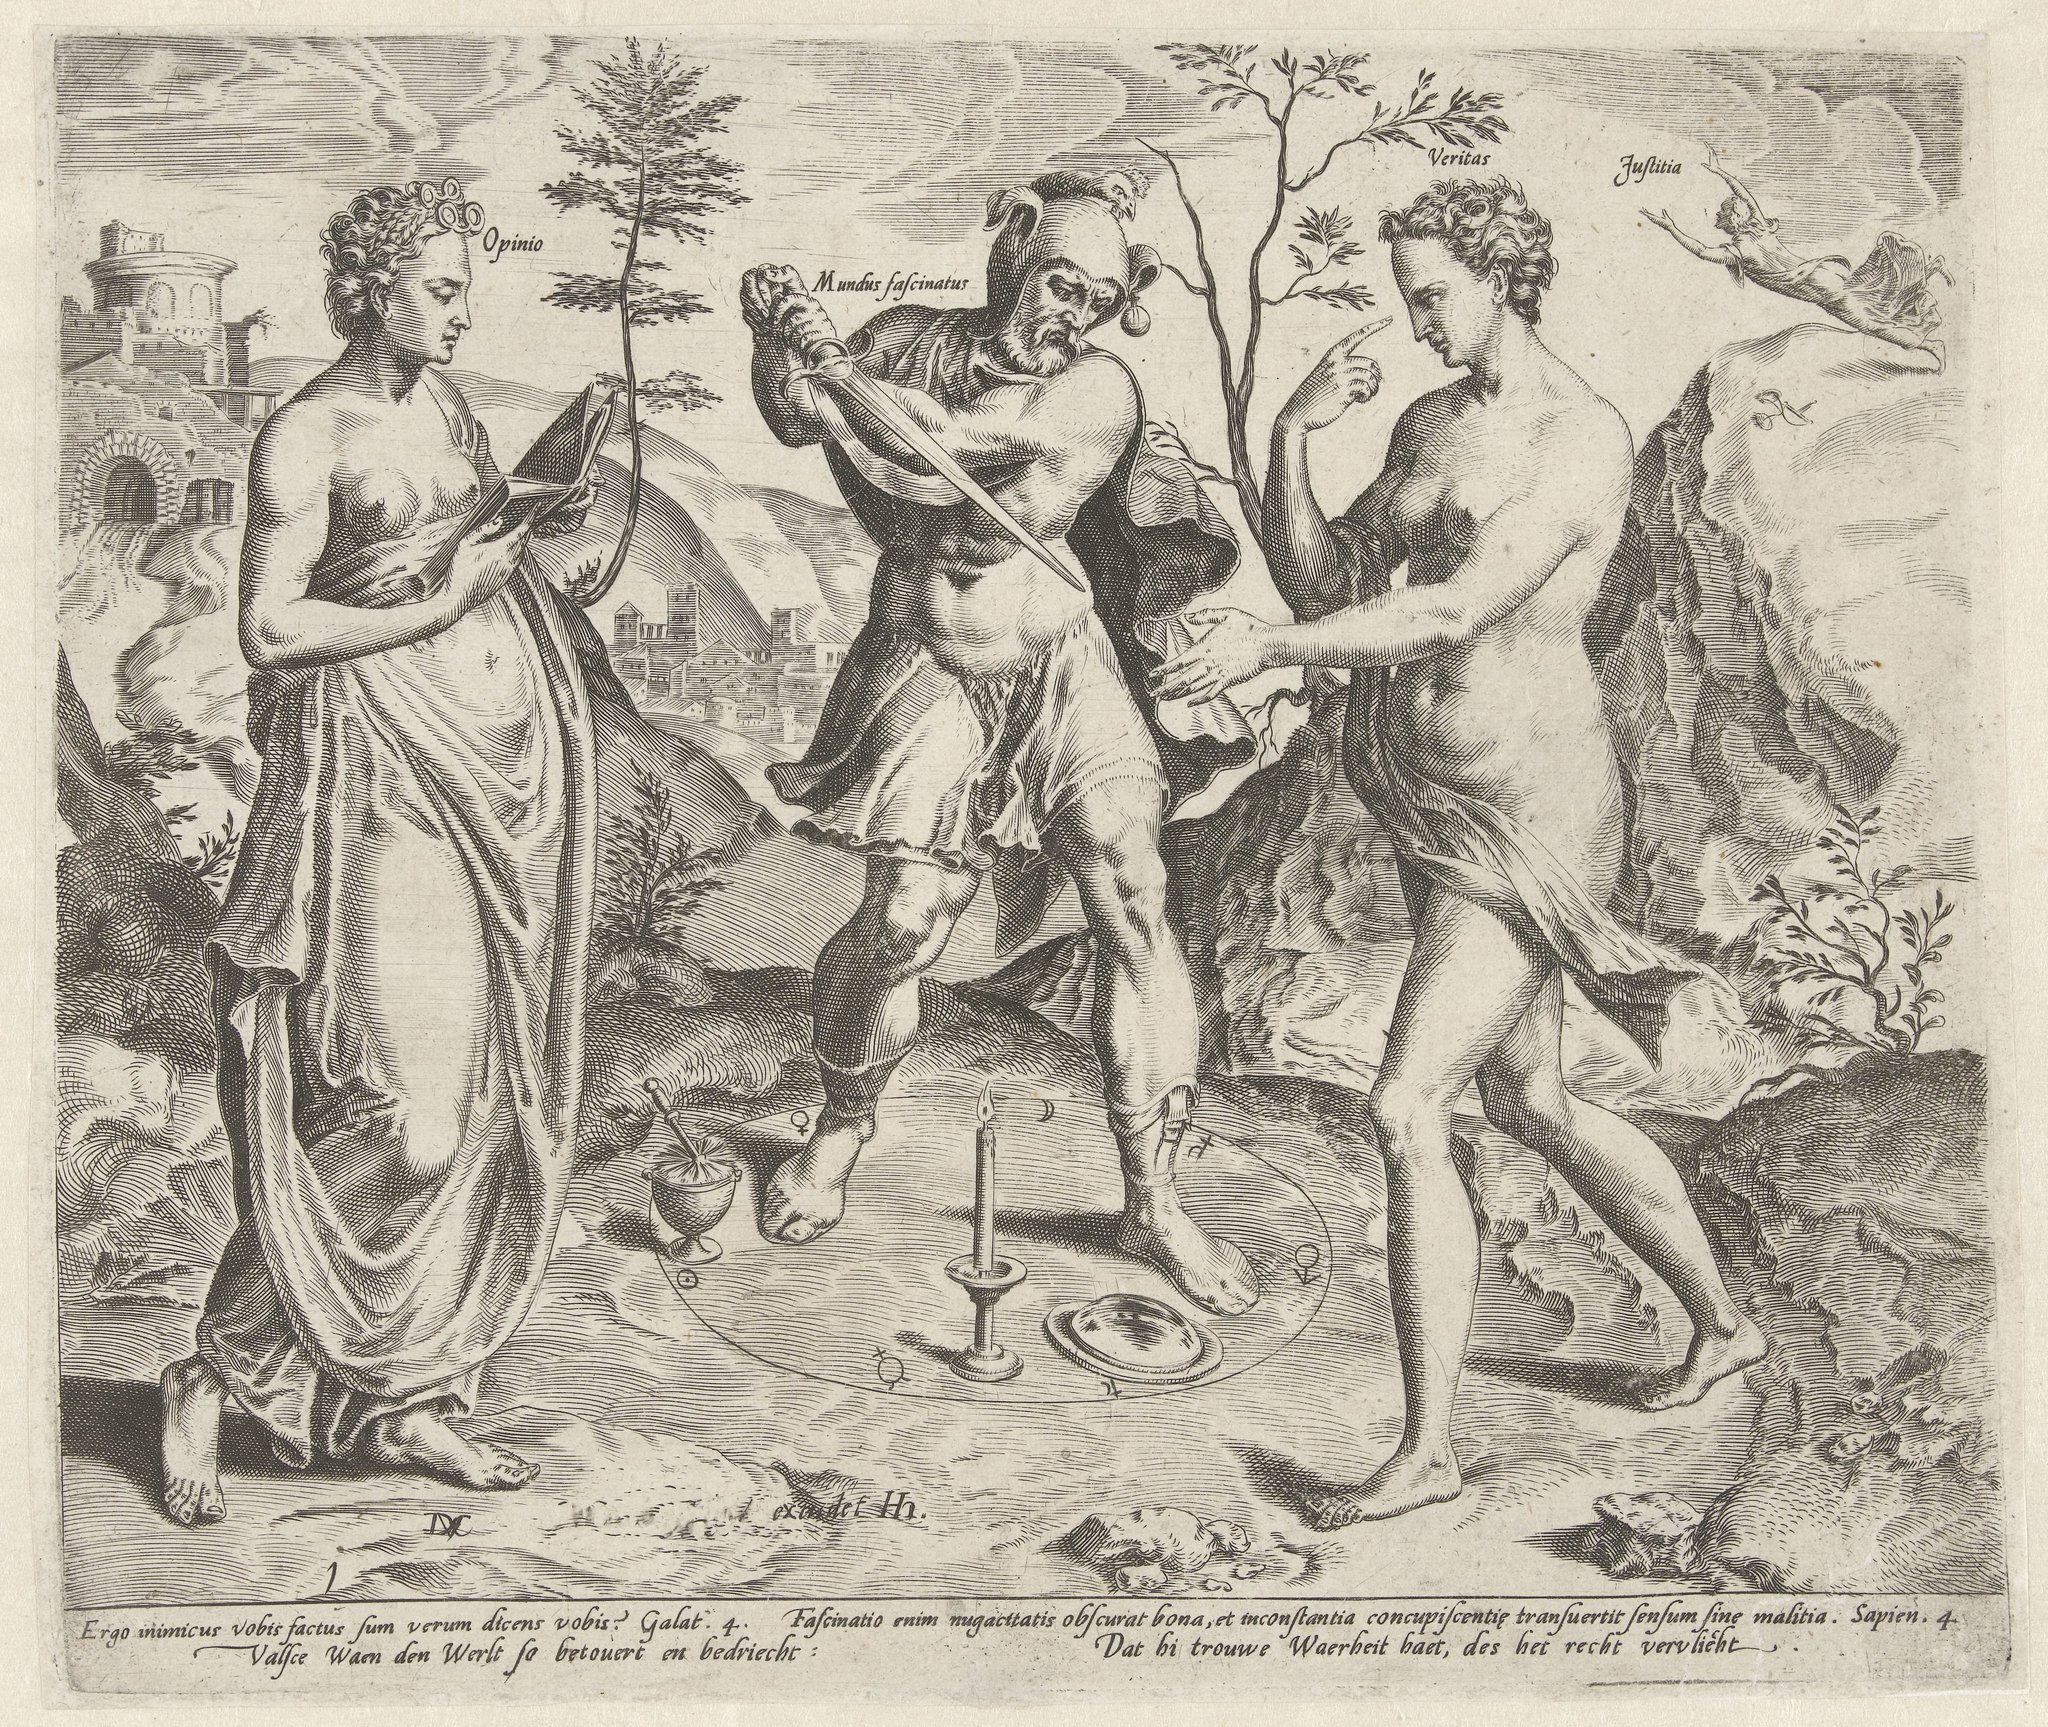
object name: print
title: Verkeerde overtuiging richt de wereld te gronde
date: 1575-1581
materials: paper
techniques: engraving, etching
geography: haarlem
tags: fool, simpleton, numskull, truth; 'verità' (ripa), folly, foolishness; 'pazzia', 'sciocchezza', 'stoltitia' (ripa), witchcraft, sorcery, opinion, justice, 'justitia'; 'giustitia divina' (ripa) ~ one of the four cardinal virtues - mm - triumph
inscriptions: collector's mark: Lugt 2228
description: Een man met een zotskap is de personificatie Dwaze Wereld (Mundus Fascinatus). Hij wordt betoverd door Verkeerde Overtuiging (Opinio), een vrouw met twee brillen op het voorhoofd. Zij leest uit een boek toverformules. Rondom Dwaze Wereld is een tovercirkel getrokken met de symbolen van de zeven planeten, alsook een wijwaterkwast, een bolle spiegel en een brandende kaars. De personificatie Waarheid (Veritas) probeert Dwaze Wereld te helpen, maar wordt door de betoverde Dwaze Wereld met een zwaard aangevallen. In de achtergrond stort Rechtvaardigheid zich van een rots naar beneden. De prent heeft een Latijns en een Nederlands onderschrift en is deel van een vierdelige serie met als onderwerp hoe verkeerde overtuiging de wereld te gronde richt.